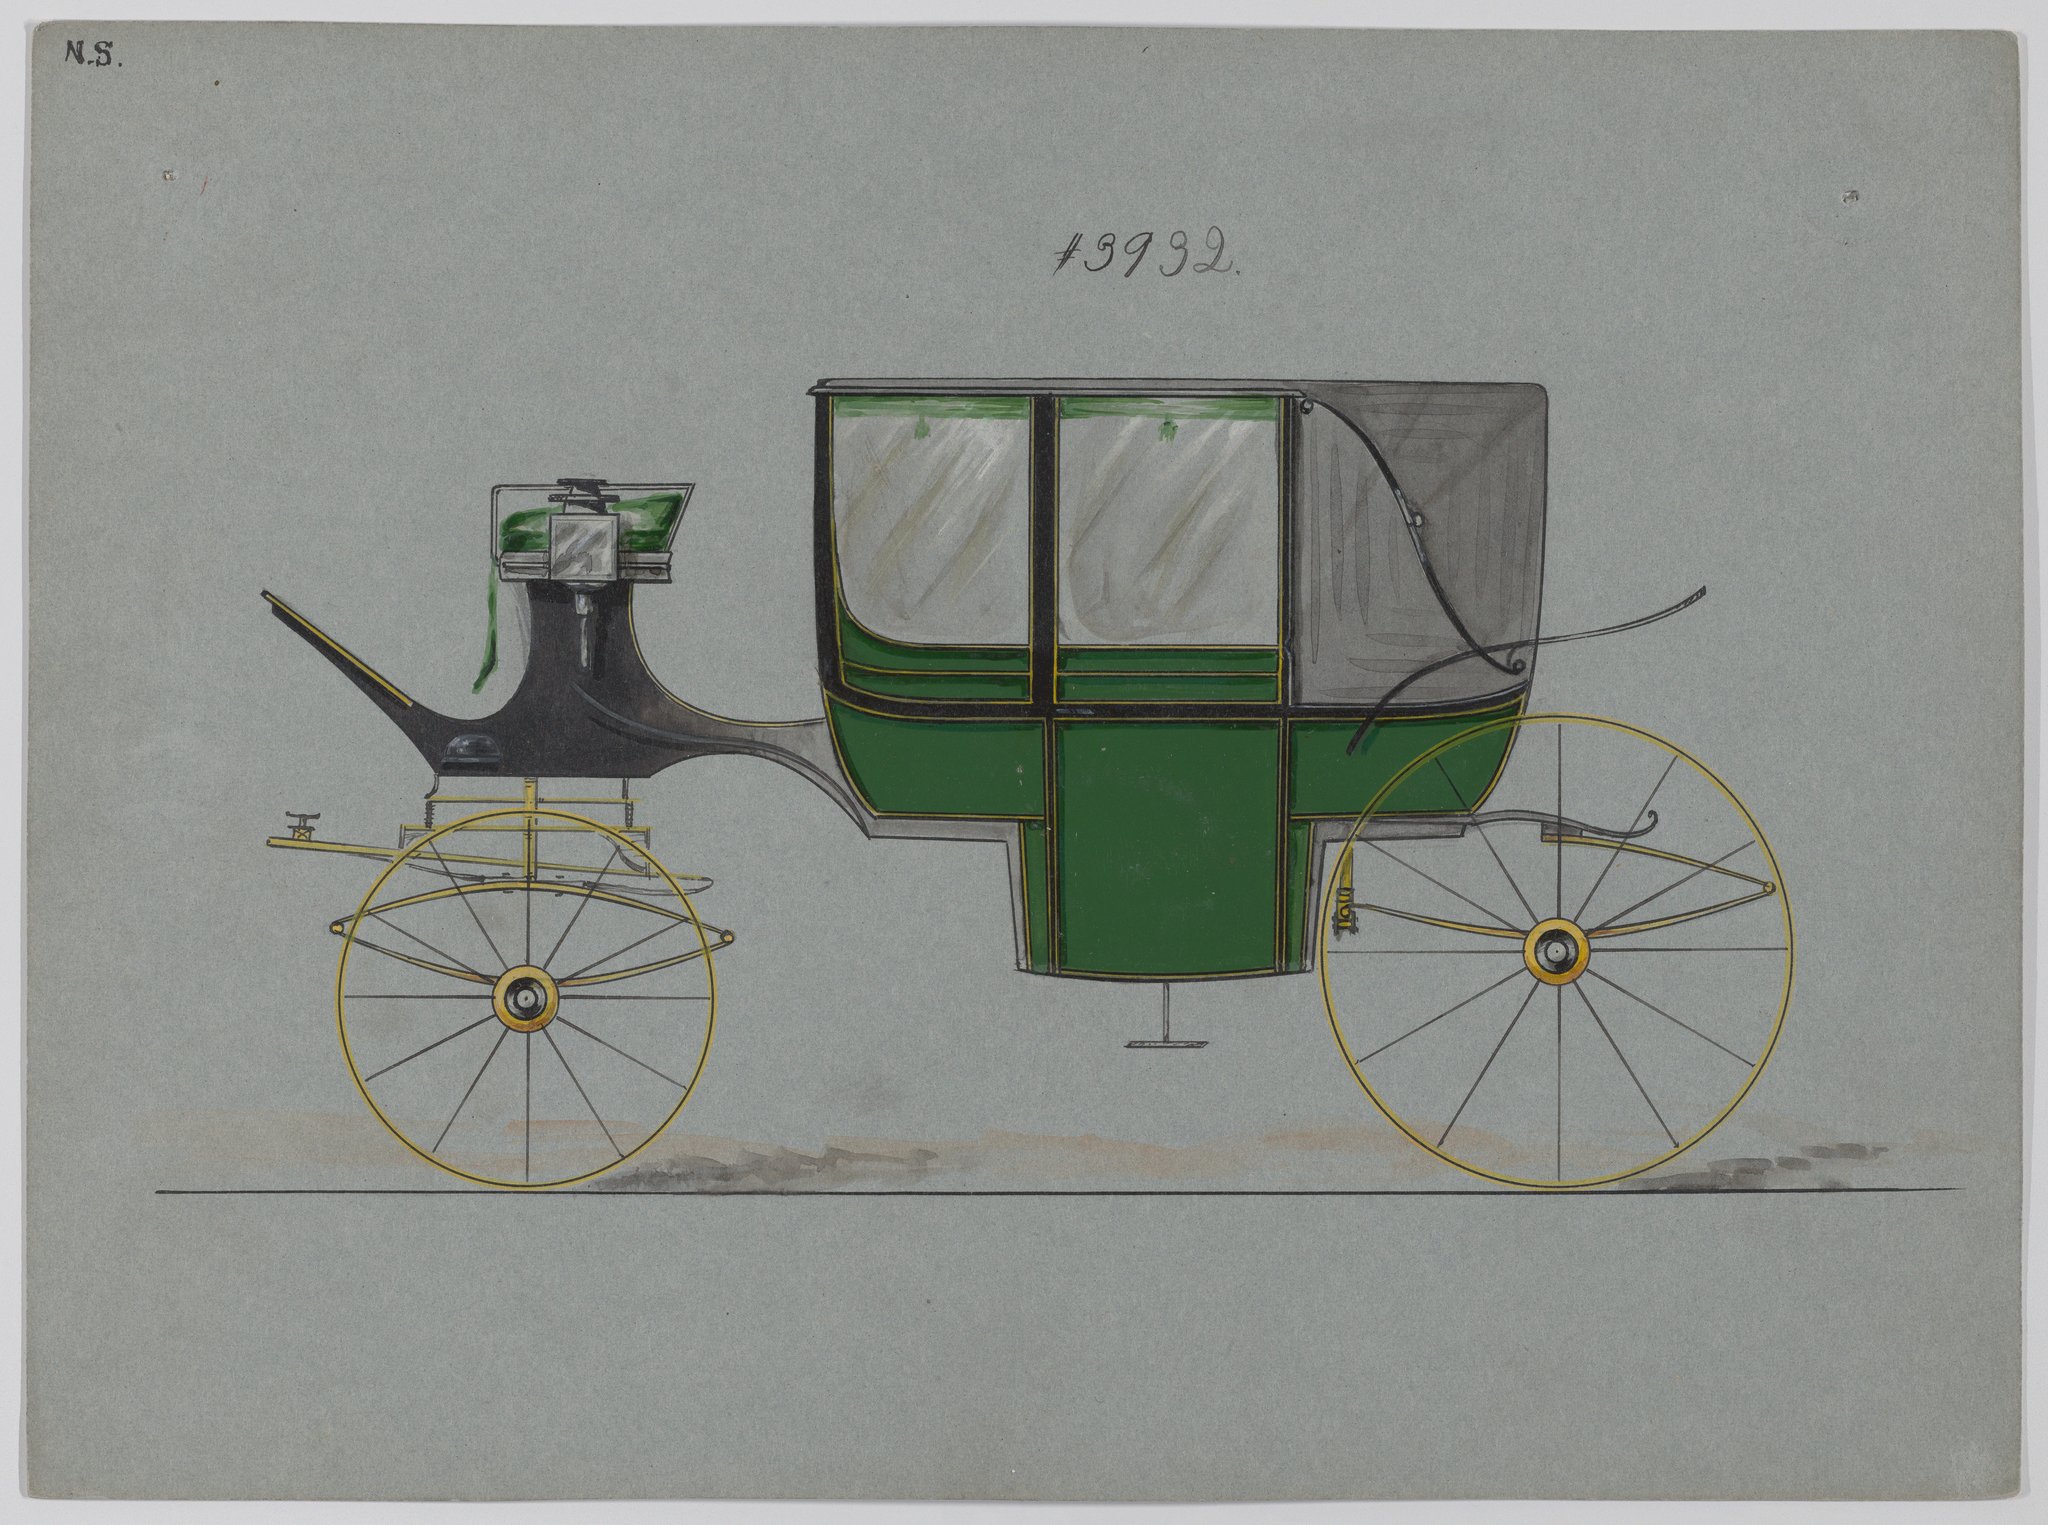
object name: drawing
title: Design for Landau, No. 3932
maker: brewster & co.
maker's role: manufacturer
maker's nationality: american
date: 1884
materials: gouache, gum arabic, ink, watercolor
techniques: pen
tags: carriages